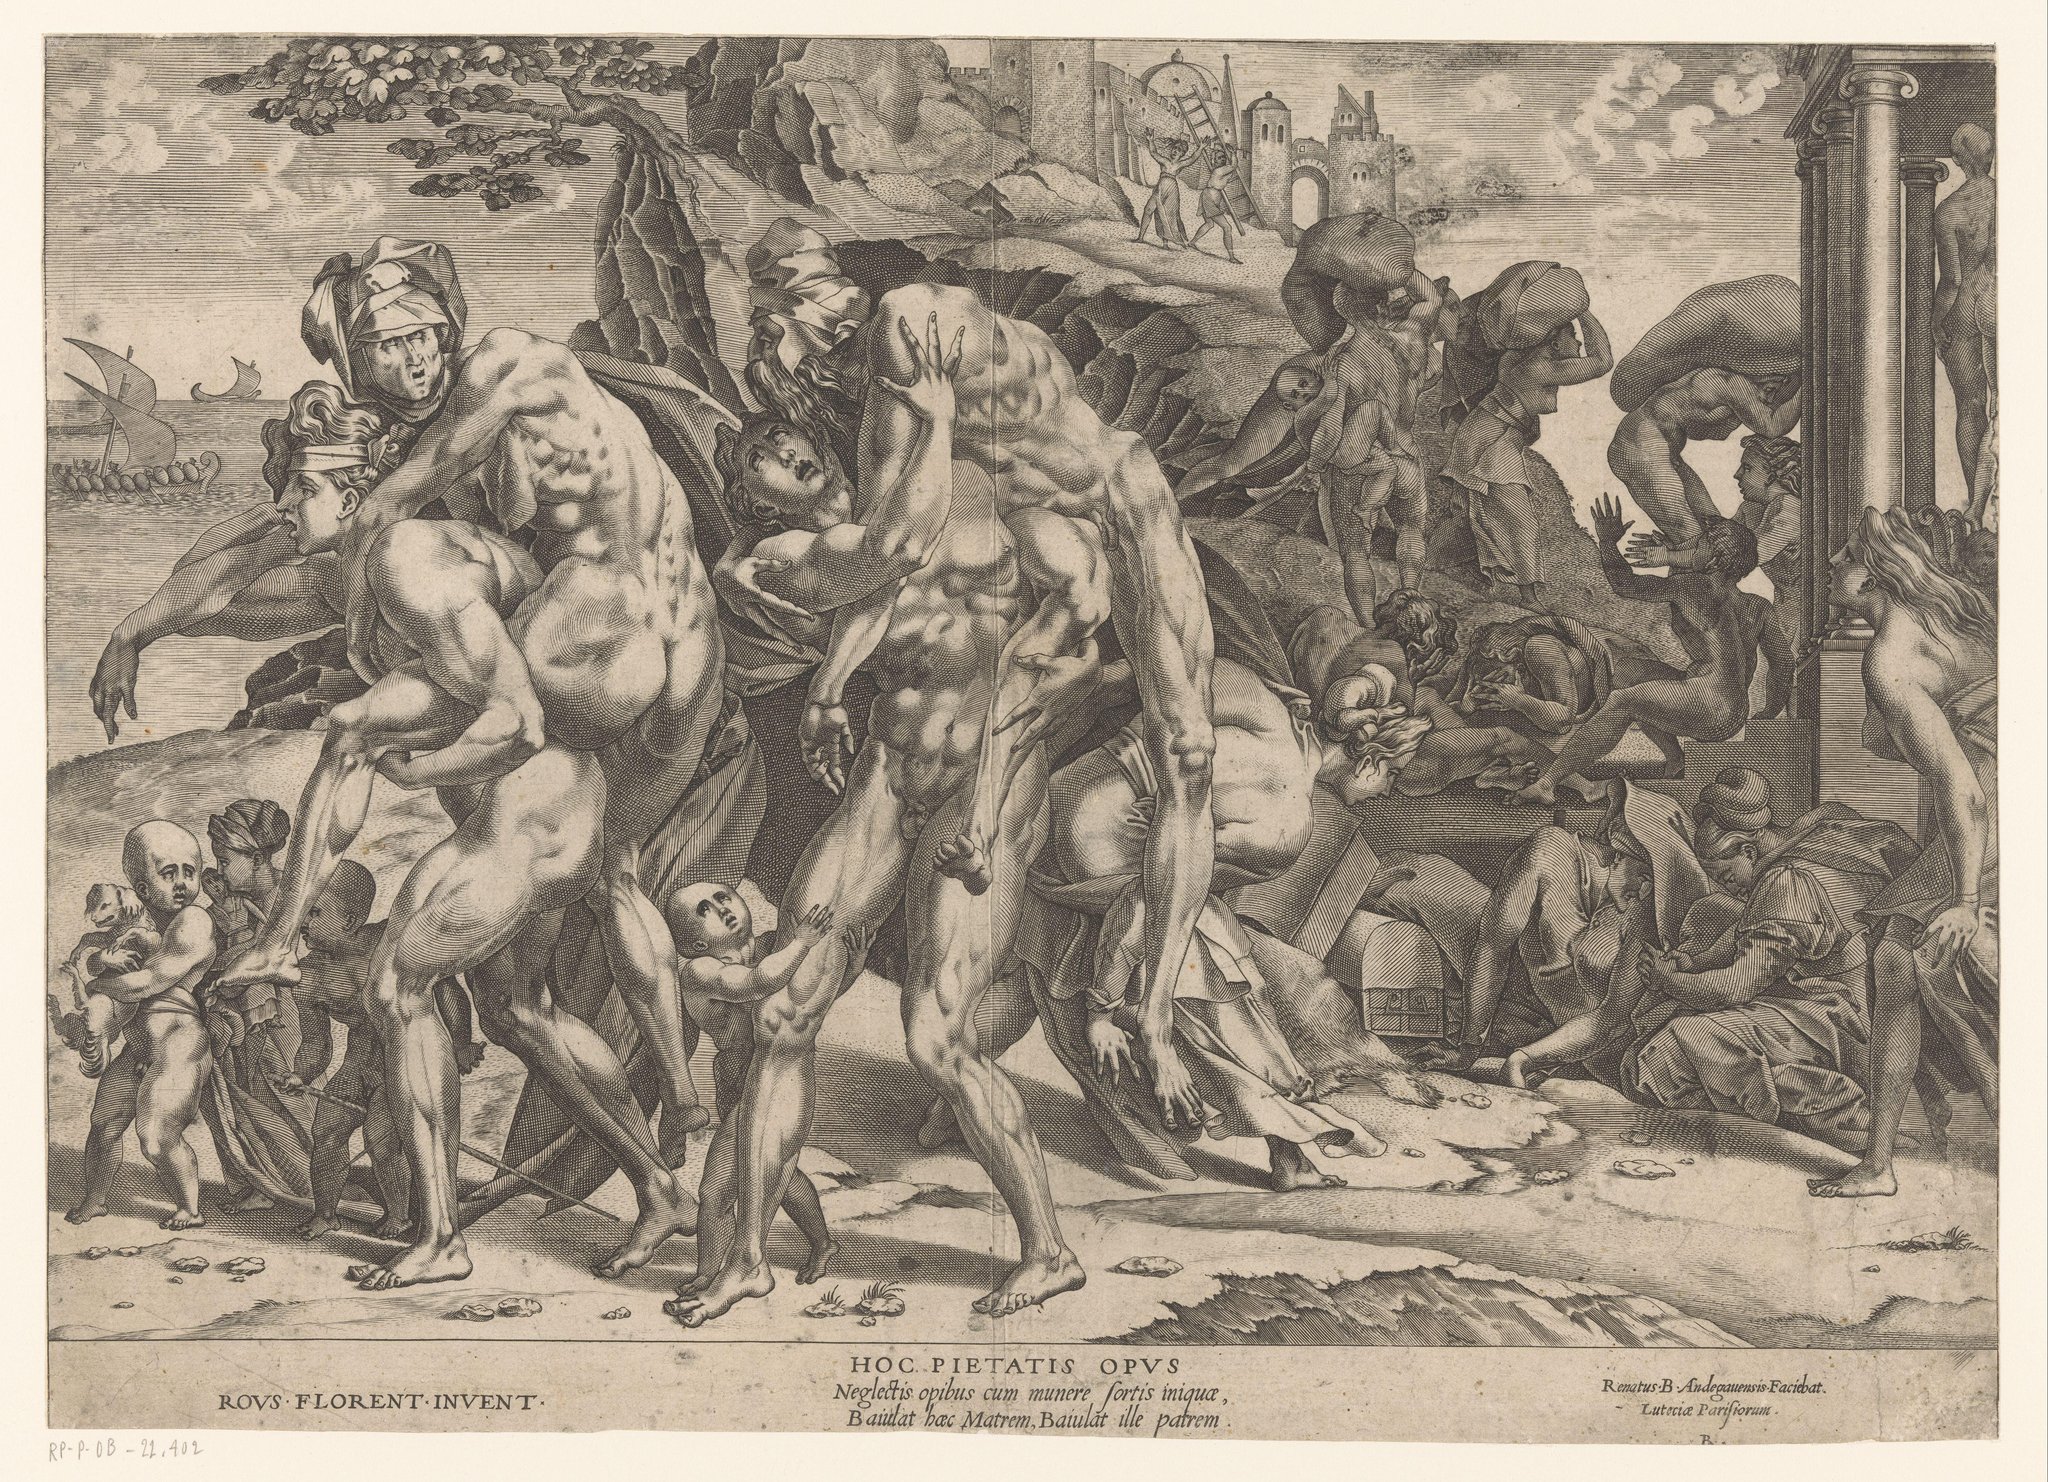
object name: print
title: Amphinomus en Anapias redden hun ouders uit de brand van Catania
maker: rené boyvin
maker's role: print maker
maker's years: 1525-1598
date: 1535-1598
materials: paper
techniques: engraving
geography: paris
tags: carrying a person, (story of) amphinomus and anapias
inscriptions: signature: ‘Renatus.B.Andegauensis.Faciebat.’, collector's mark: Lugt 2228, inscription: ‘ROUS.FLORENT.INVENT.’, monogram: ‘RB’, address: ‘Luteciae Parisiorum.’, caption: ‘HOC PIETATIS OPUS//Neglectis opibus cum munere fortis iniquae,//Baiulat haec Matrem, Baiulat ille patrem.’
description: Het schilderij door Fiorentino bevond zich in de galerie François I, Fontainebleau, ca. 1535-1540.